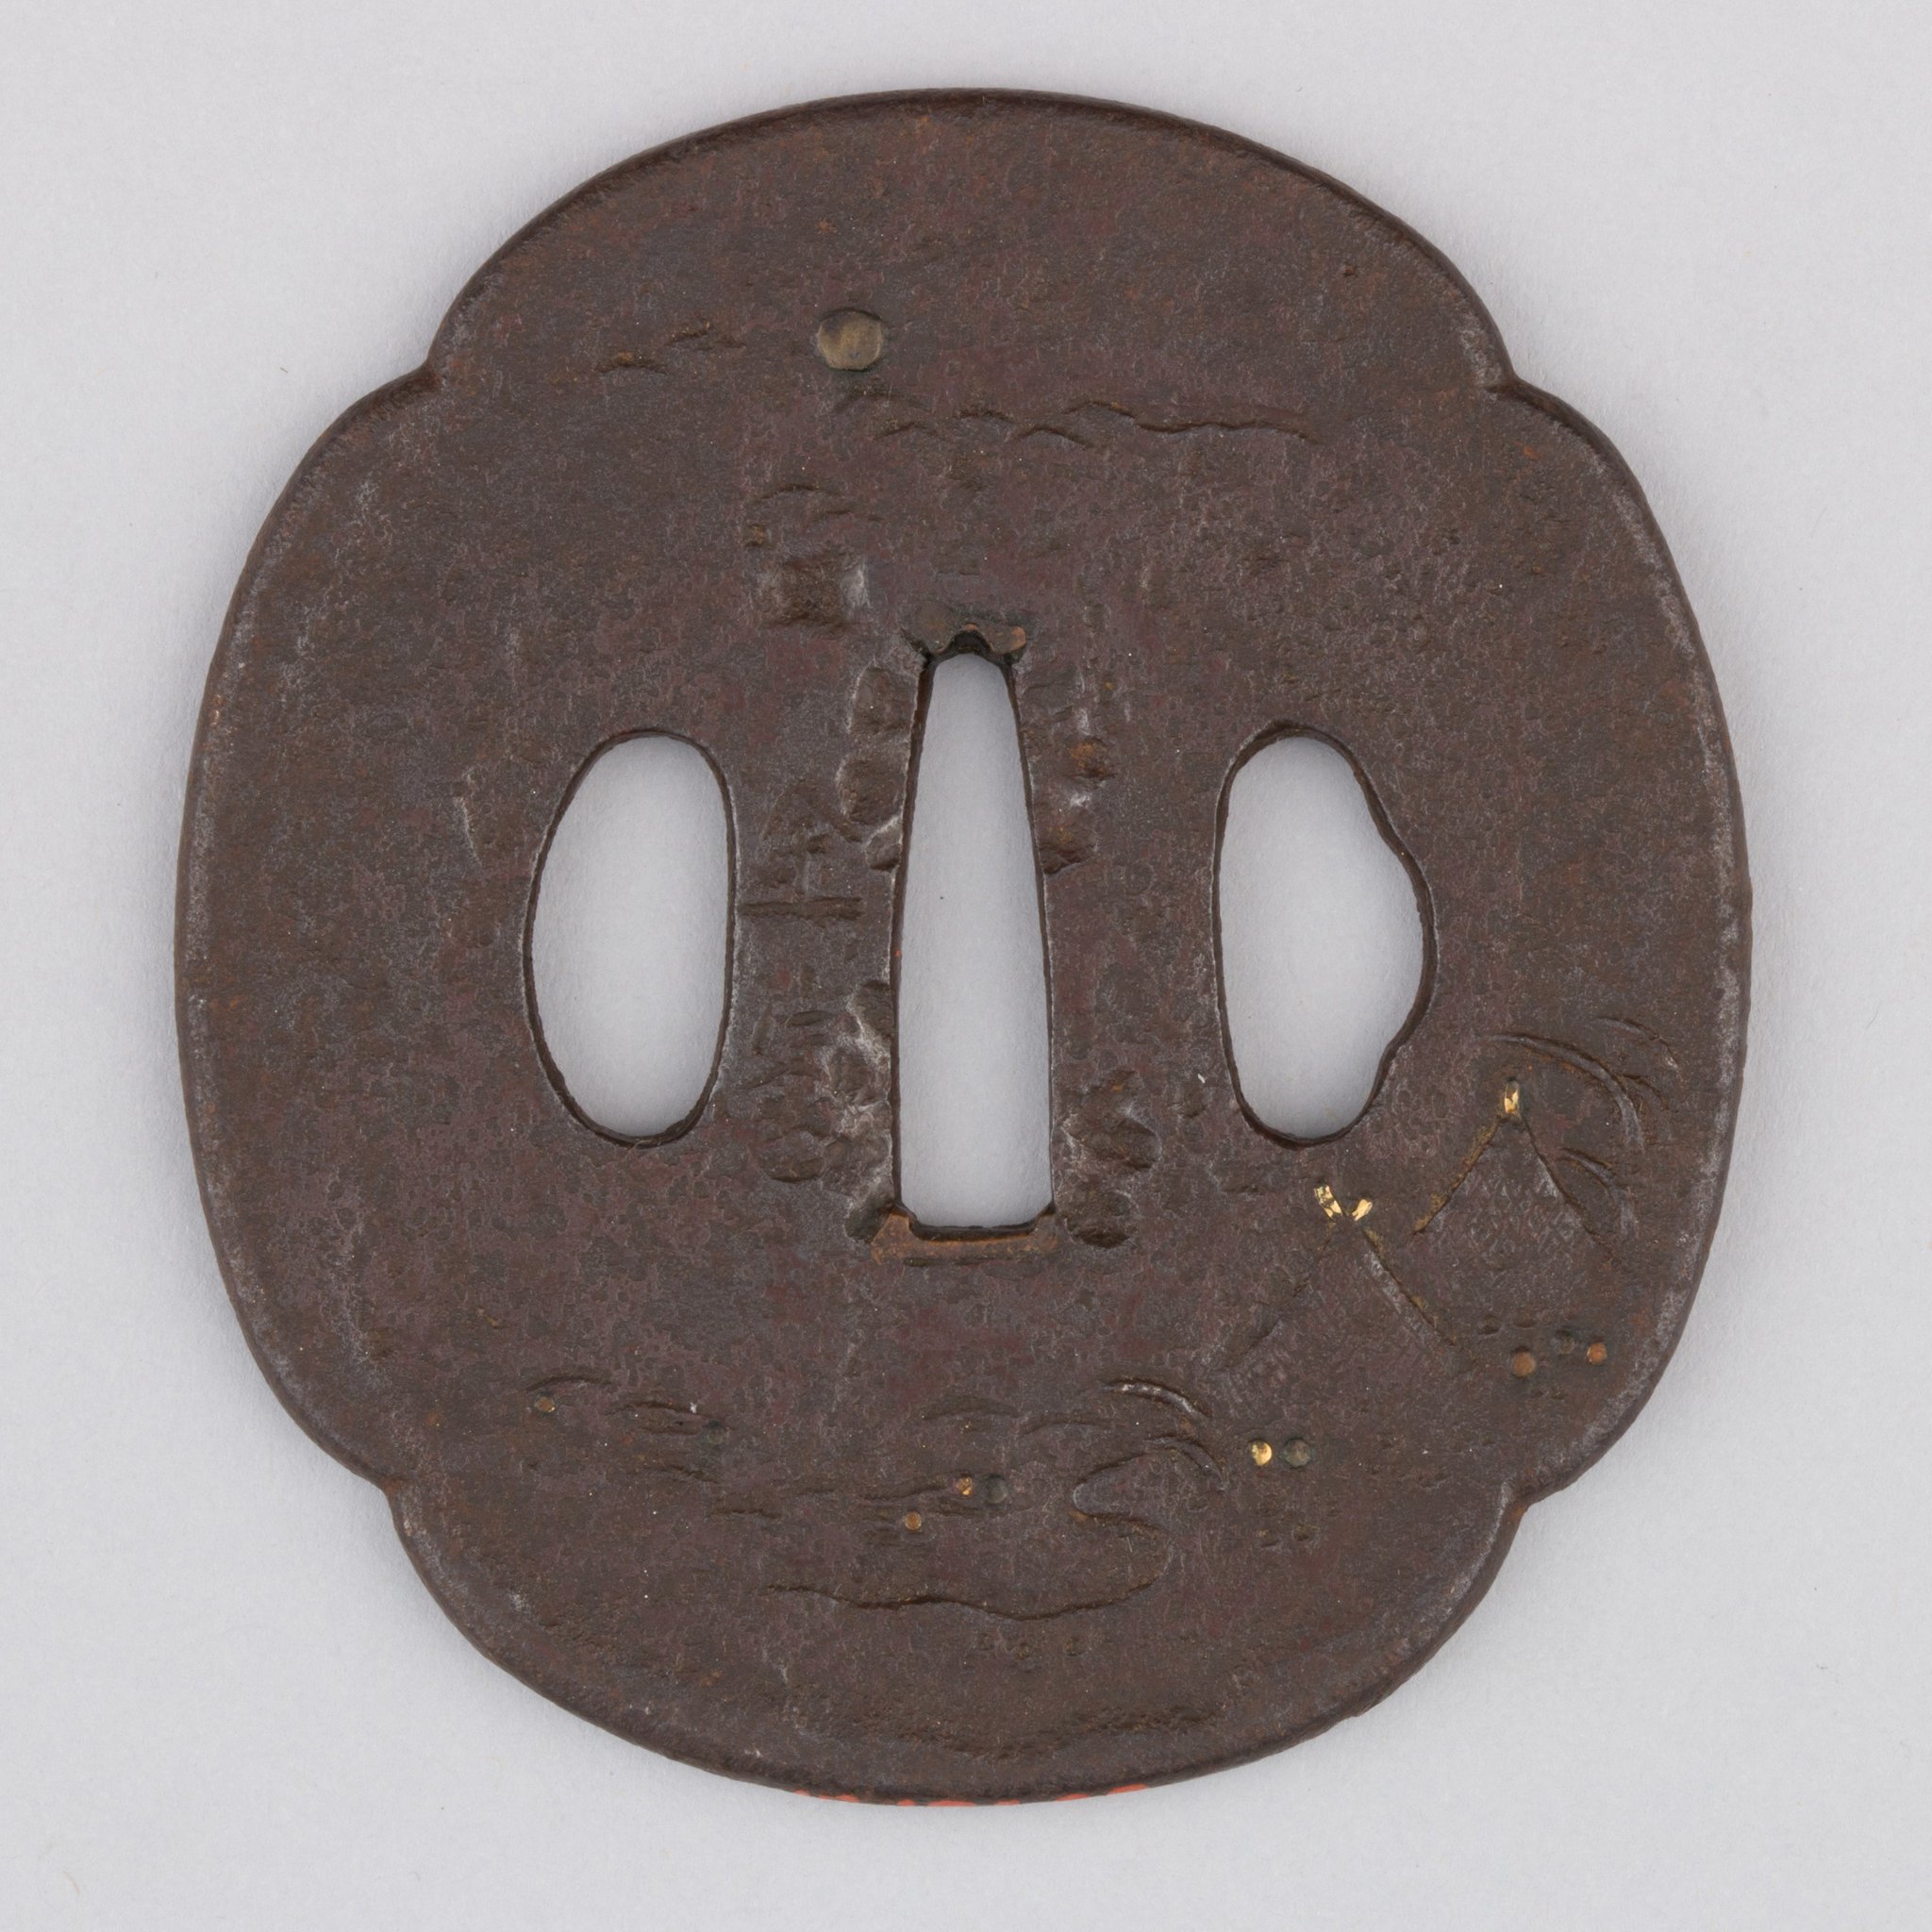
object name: sword guard tsuba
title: Sword Guard (Tsuba)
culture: japanese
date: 1615-1868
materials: copper, iron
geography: japan